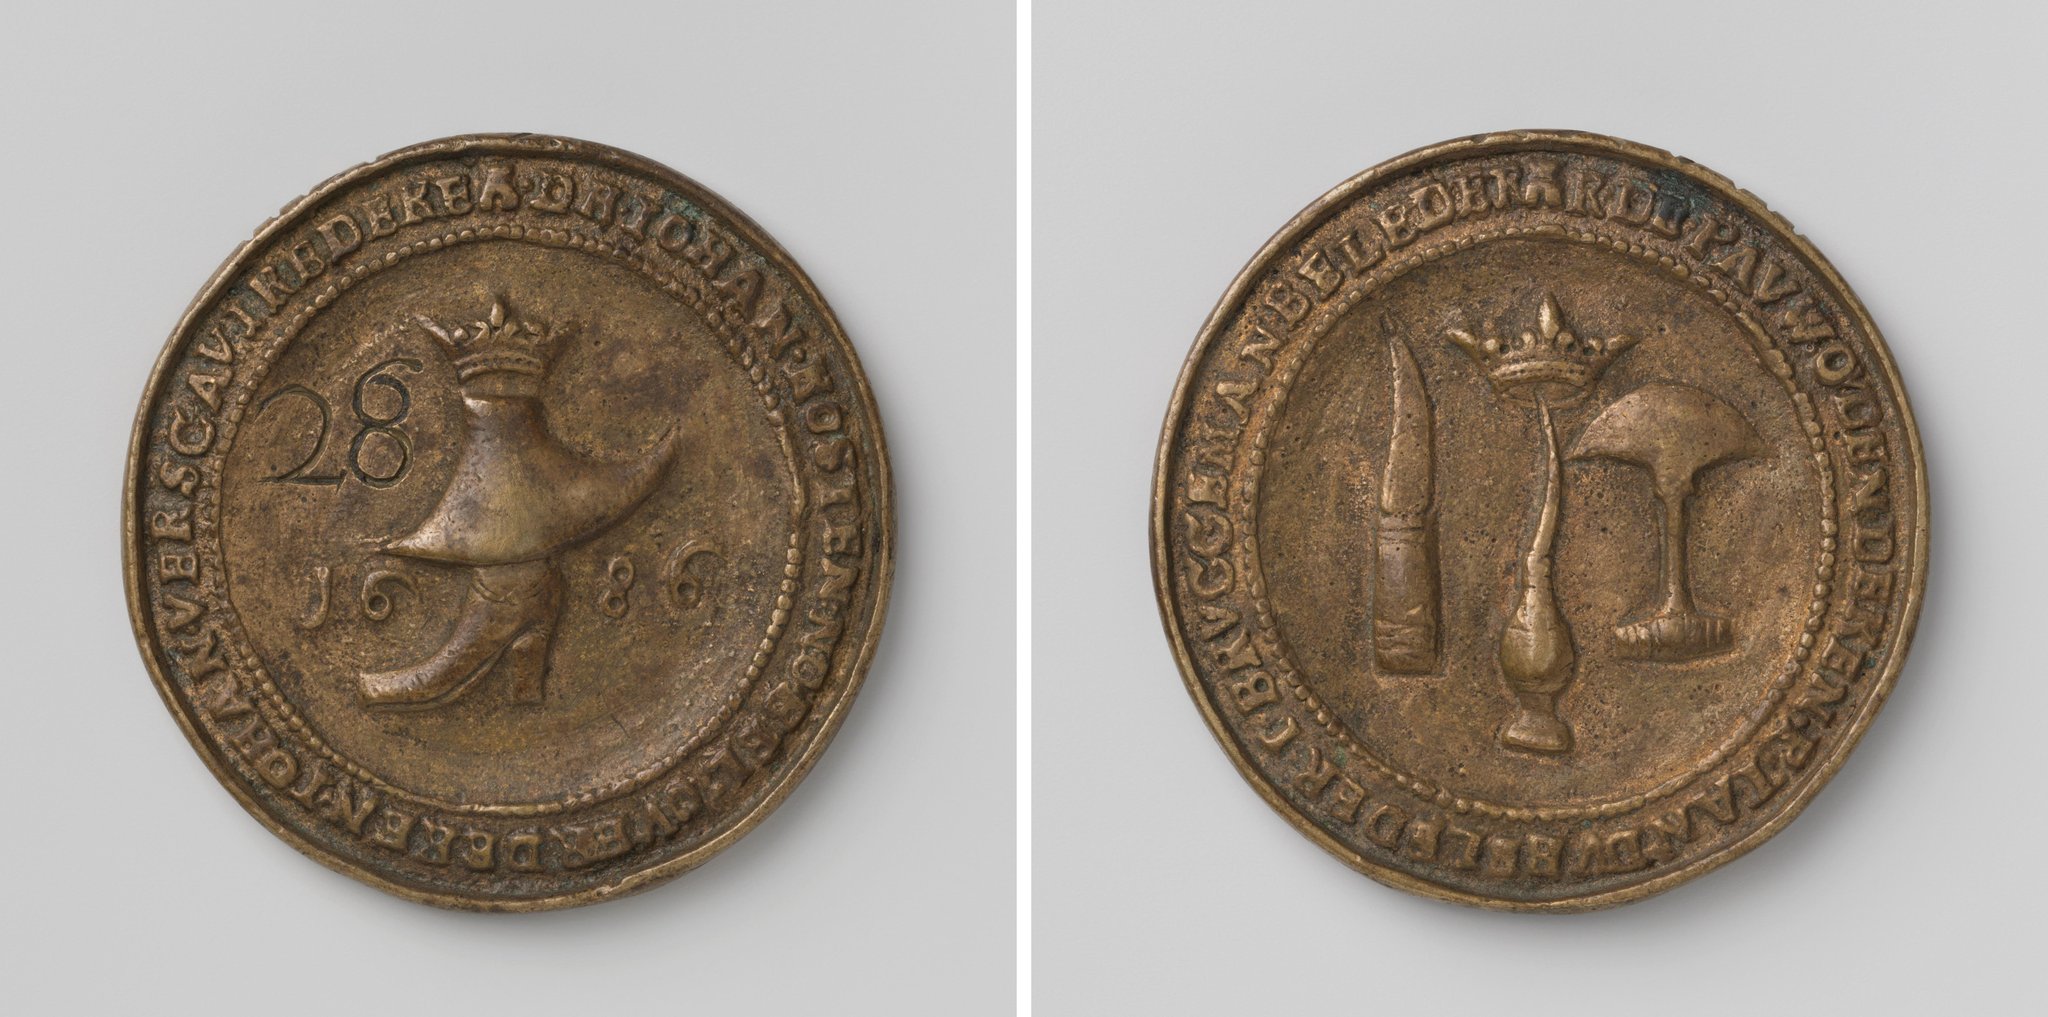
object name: medal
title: Schoenmakers-, huidenvetters- en leerverkopersgilde van Middelburg, gildepenning met no. 28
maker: Anonymous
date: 1686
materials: brass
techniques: casting, engraving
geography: middelburg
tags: middelburg